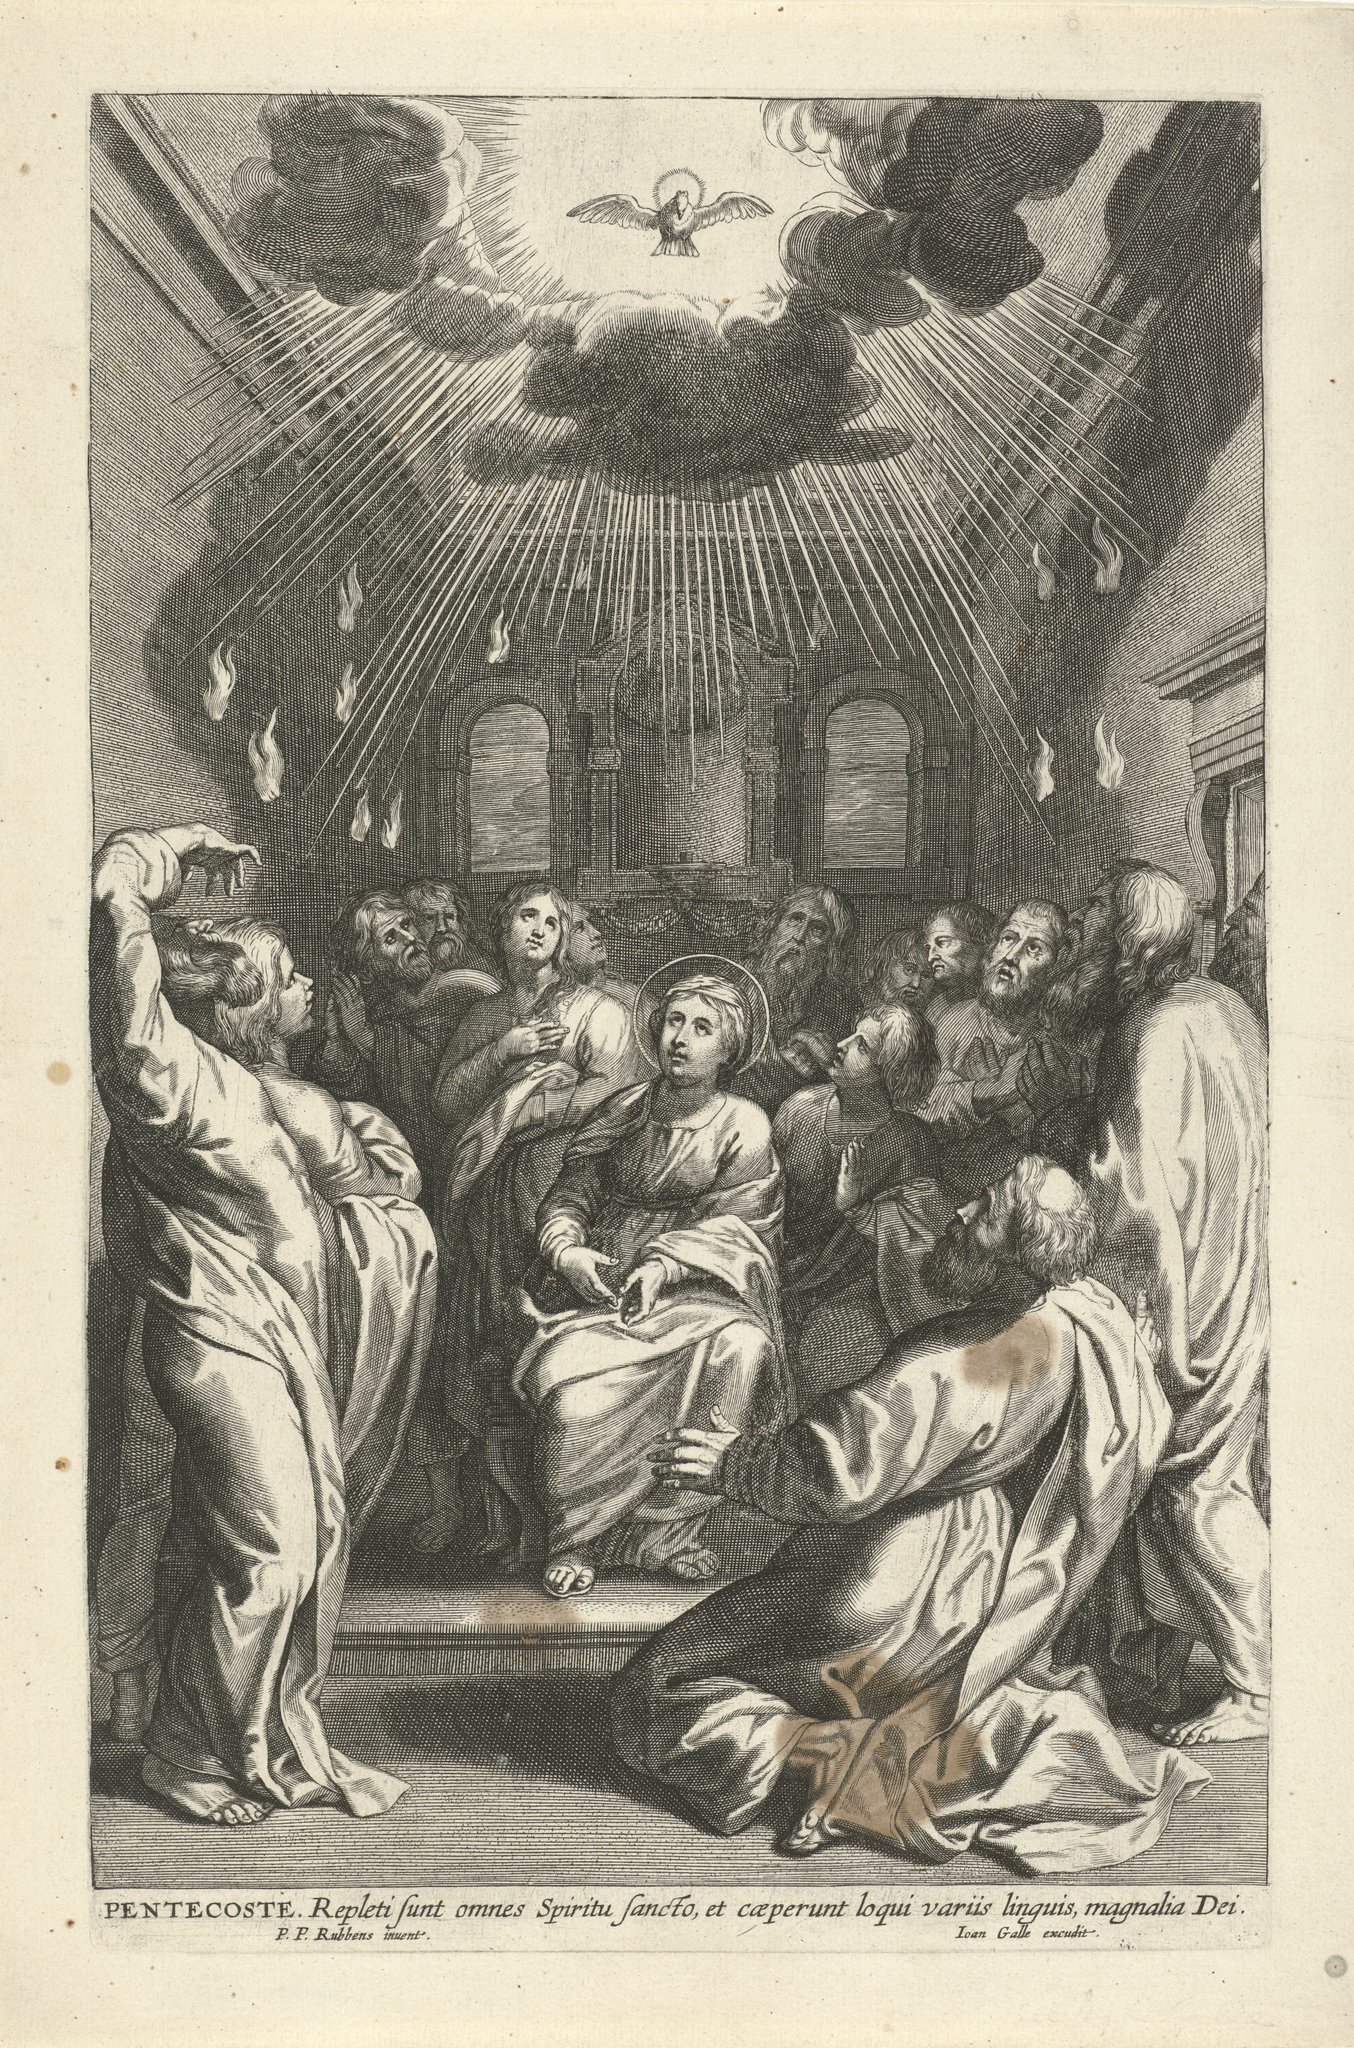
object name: print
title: Pentecoste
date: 1614-1676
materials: paper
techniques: engraving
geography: antwerp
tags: pentecost: the holy ghost descends upon (mary and) the apostles, sometimes paul and/or representatives of the nations present (acts 2:1-4)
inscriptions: collector's mark: Lugt 240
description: Maria en de leerlingen van Christus zitten in een kamer. Temidden van de groep verschijnt de duif van de Heilige Geest. Boven de hoofden van de apostelen en Maria branden vurige tongen, symbool van de uitstorting van de Heilige Geest in hun harten. De prent heeft een Latijns onderschrift.